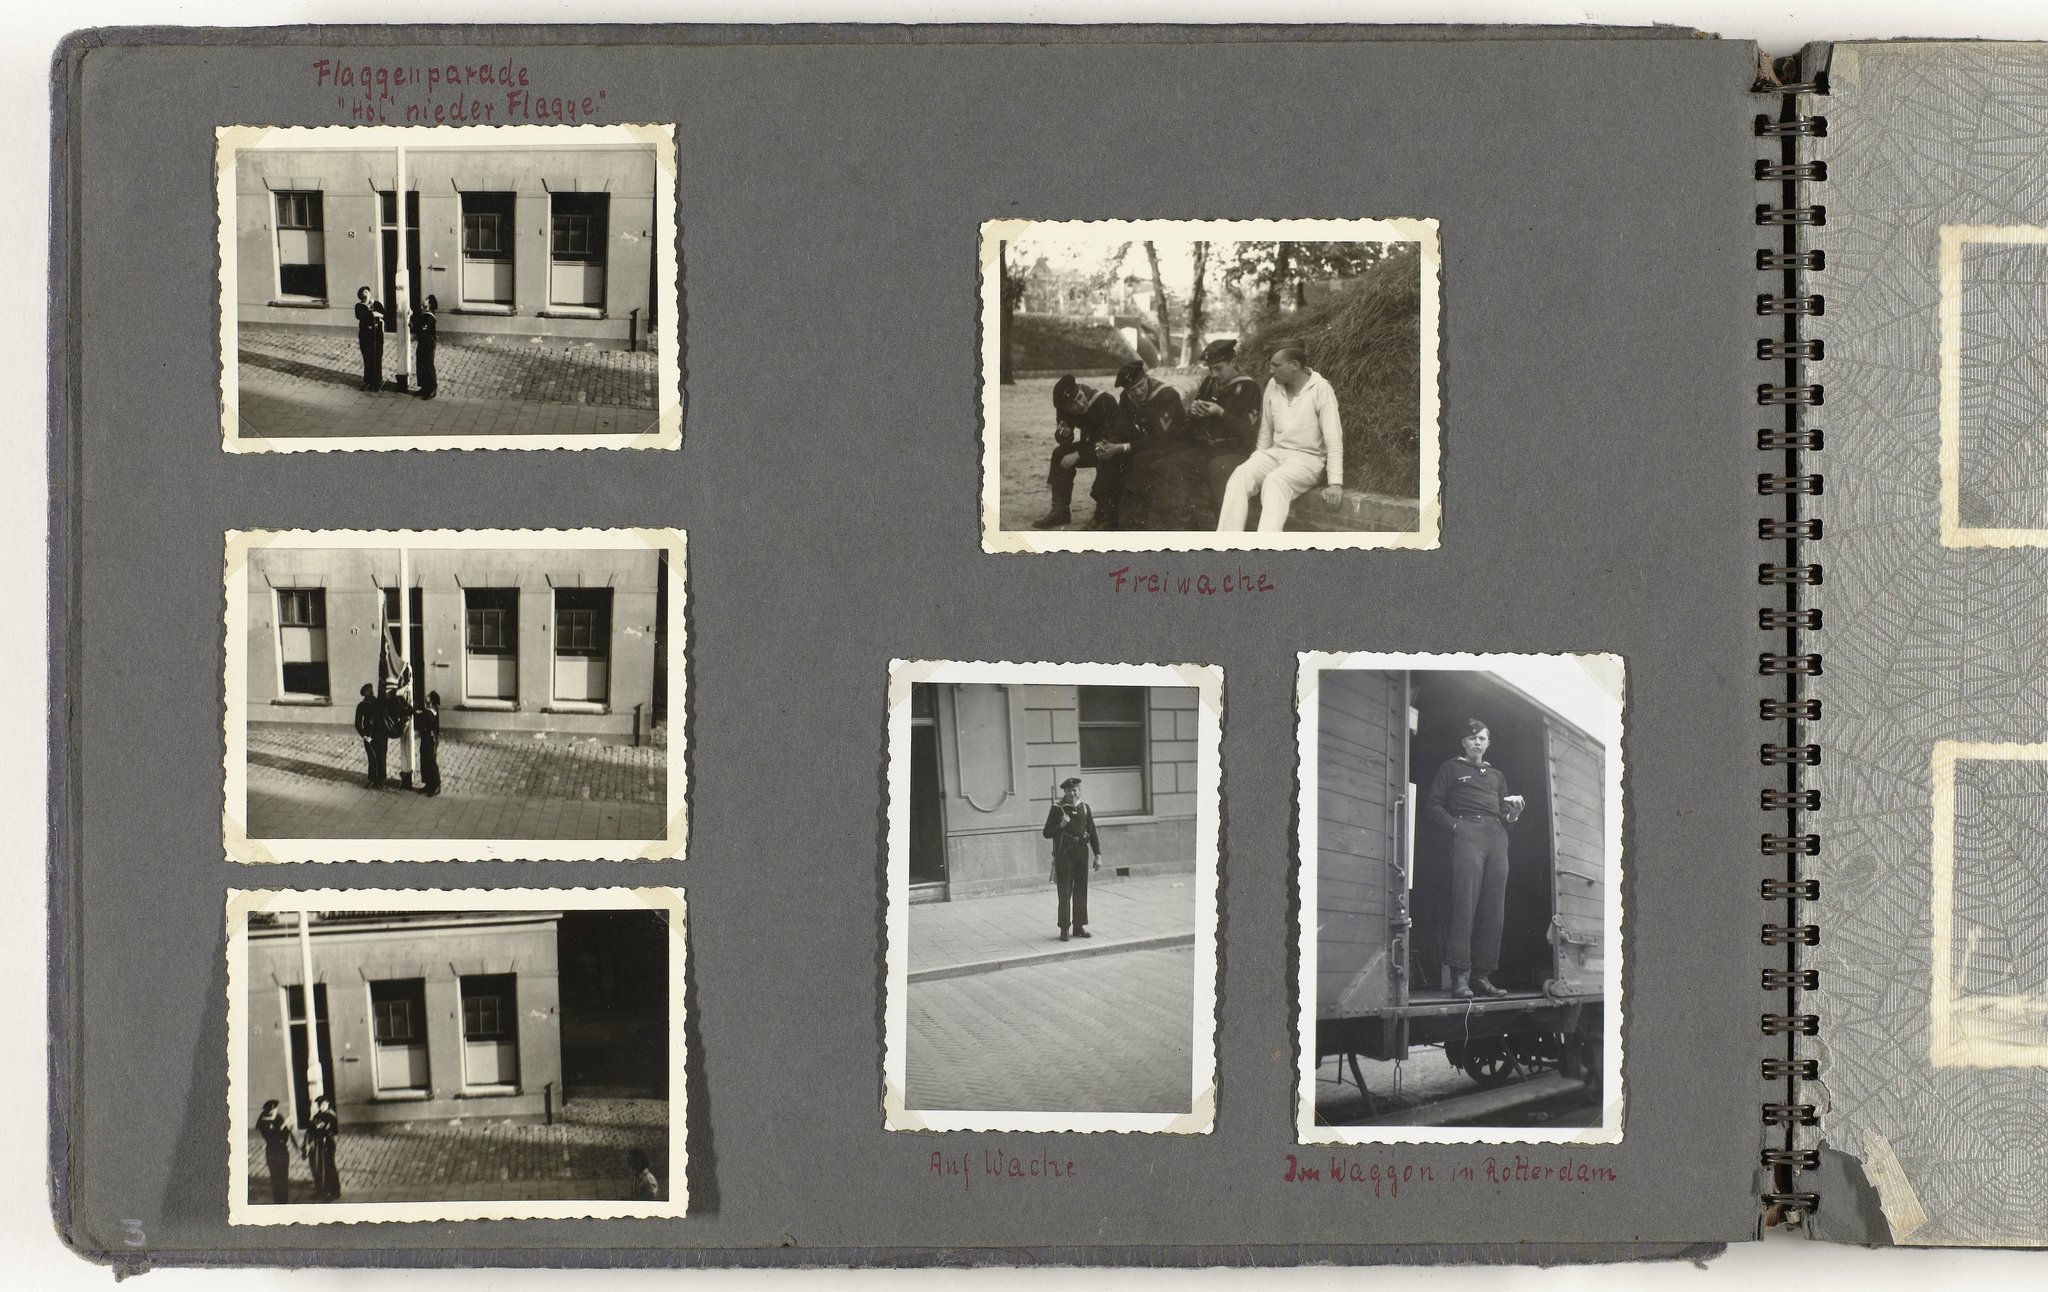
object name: album leaf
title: Het neerhalen van de Nederlandse vlag en hijsen van de hakenkruisvlag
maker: Anonymous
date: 1941-1945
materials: paper, photographic support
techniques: gelatin silver print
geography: rotterdam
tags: flag display, occupation ~ war, rotterdam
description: Albumblad met zes foto's. Het neerhalen van de Nederlandse vlag en hijsen van de hakenkruisvlag. Rechtsonder twee foto's van de samensteller van het album: op wacht en in de deur van een treinwagon in Rotterdam. Onderdeel van het fotoalbum van Heinrich Clausen over de Kriegsmarine.